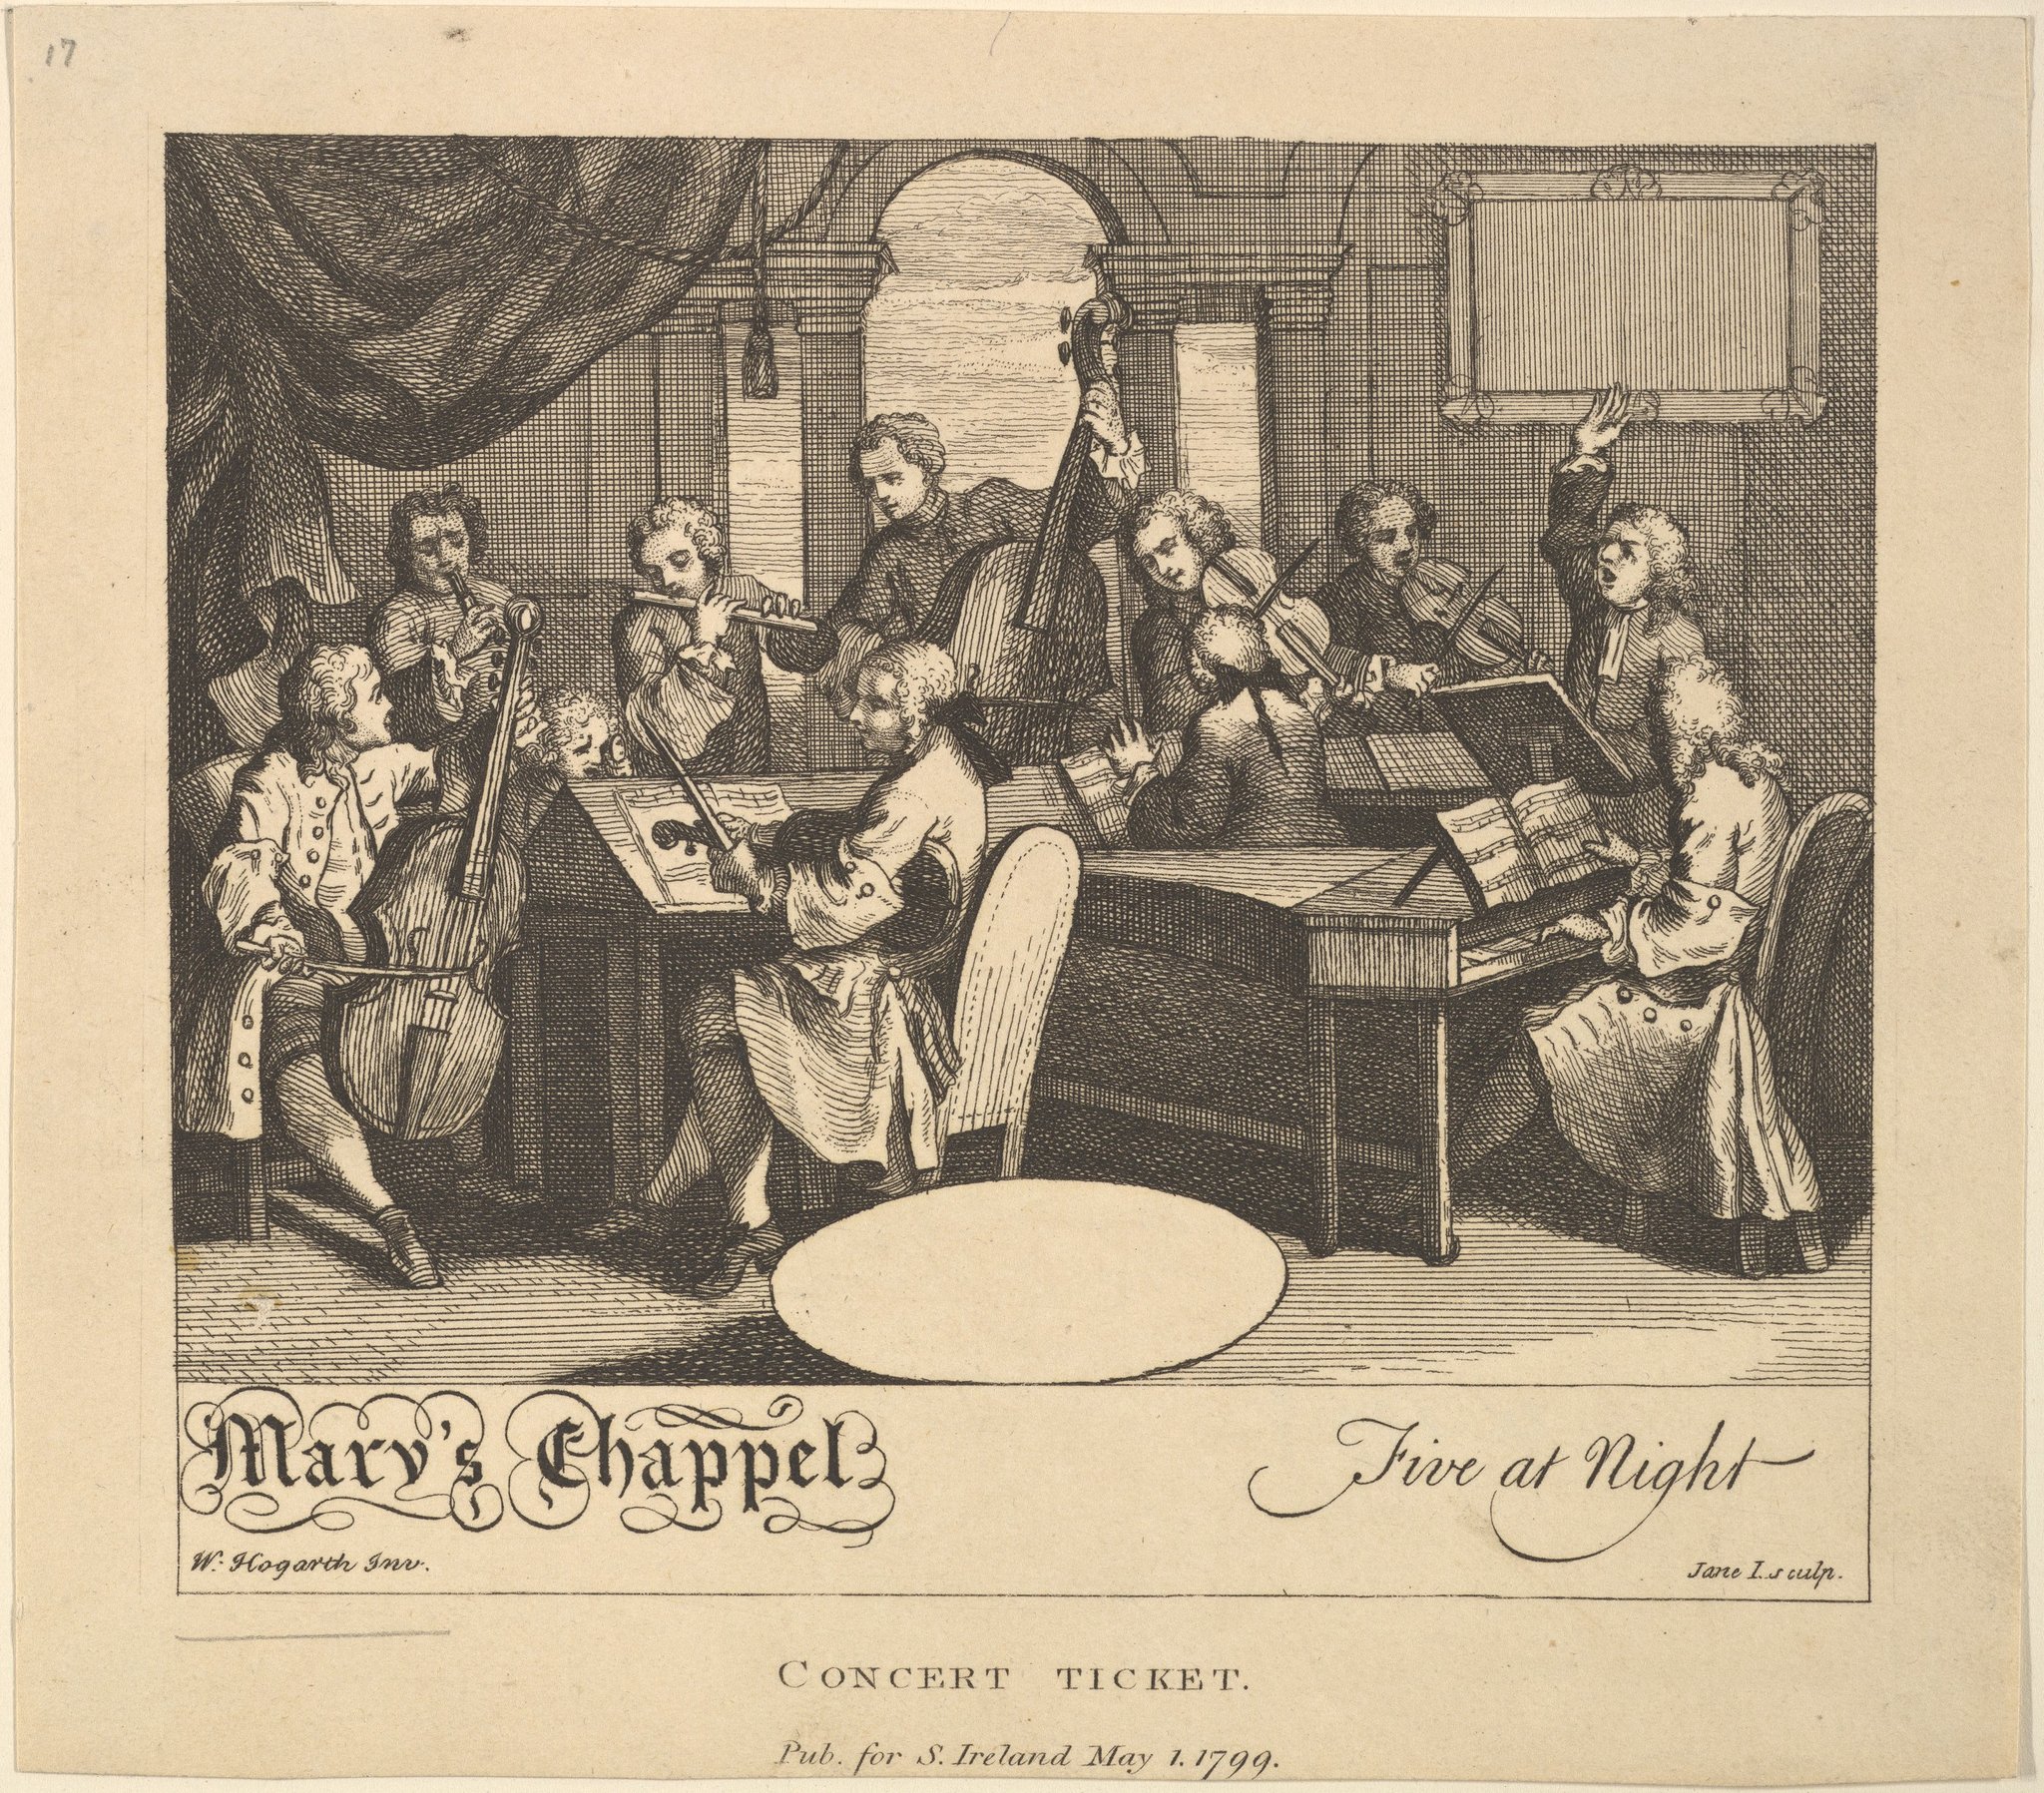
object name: print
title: Concert Ticket - Mary's Chappel, Five at Night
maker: jane ireland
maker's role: etcher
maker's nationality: british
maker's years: 1790-1800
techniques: engraving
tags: human figures,musical instruments,concerts,music,musicians